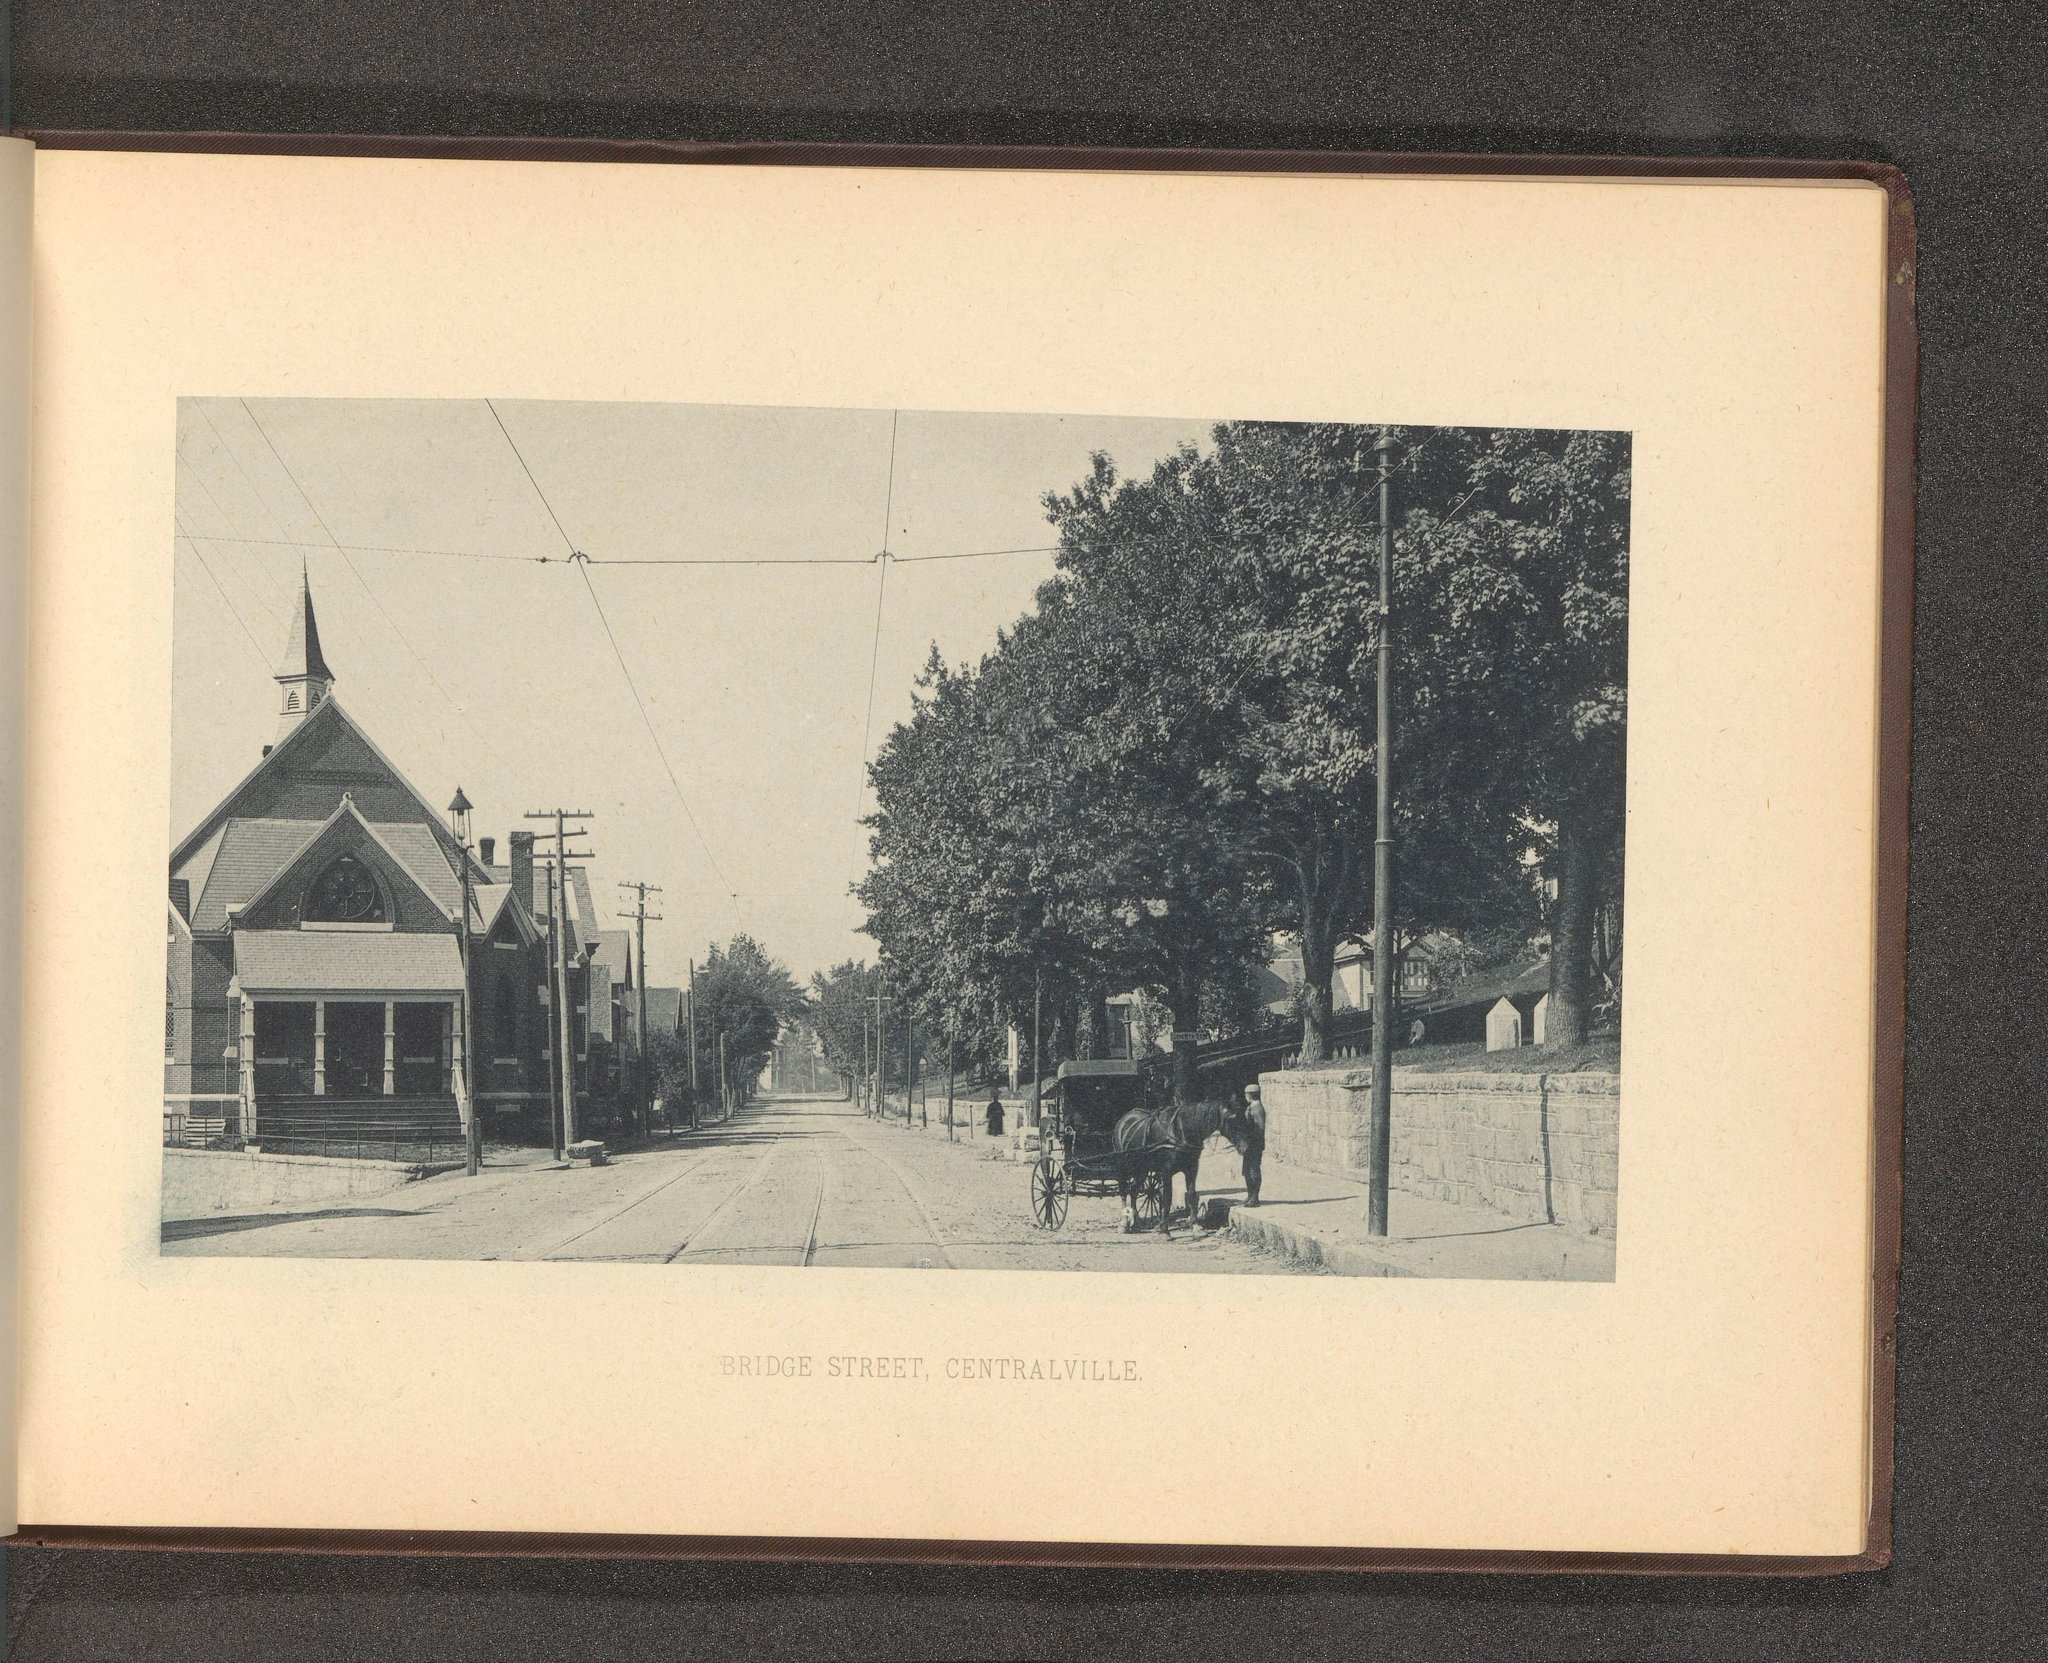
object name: page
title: Gezicht op Bridge street te Lowell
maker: Anonymous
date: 1887-1892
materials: paper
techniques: photograph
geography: lowell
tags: four-wheeled vehicle drawn by one animal, street